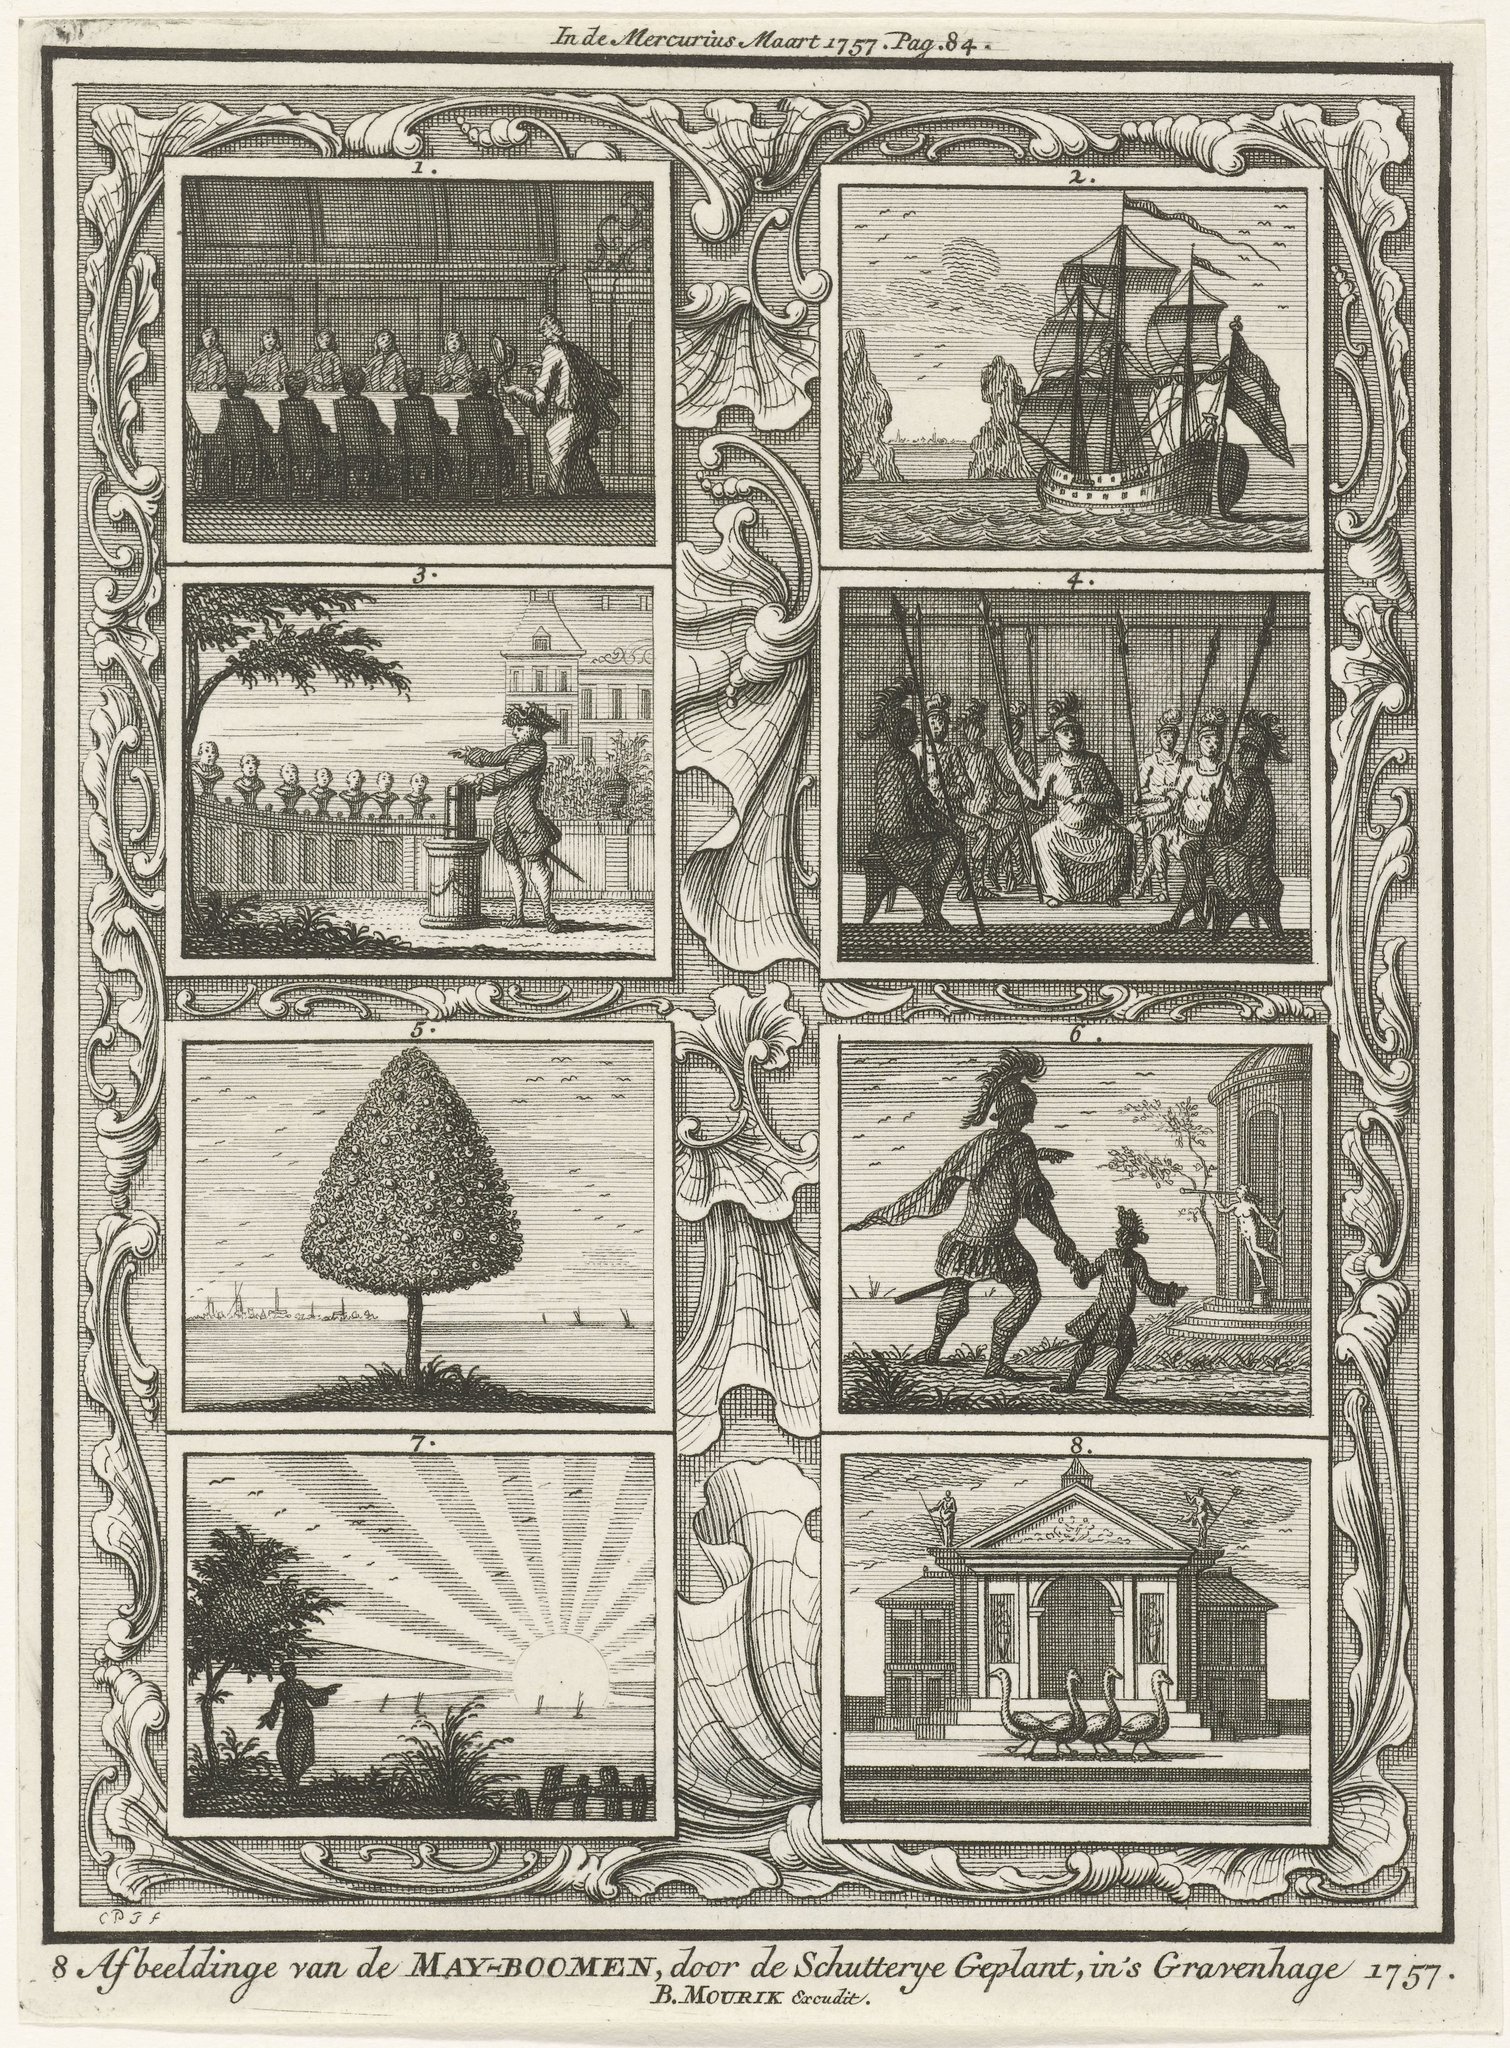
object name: print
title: Meiboom geplant door de Haagse Schutterij, 1757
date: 1757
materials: paper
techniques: engraving, etching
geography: northern netherlands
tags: maypole, the hague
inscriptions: collector's mark: Lugt 2228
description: De acht allegorische voorstellingen of emblemen van de meiboom geplant door de Schutterij van Den Haag in het jaar 1757.